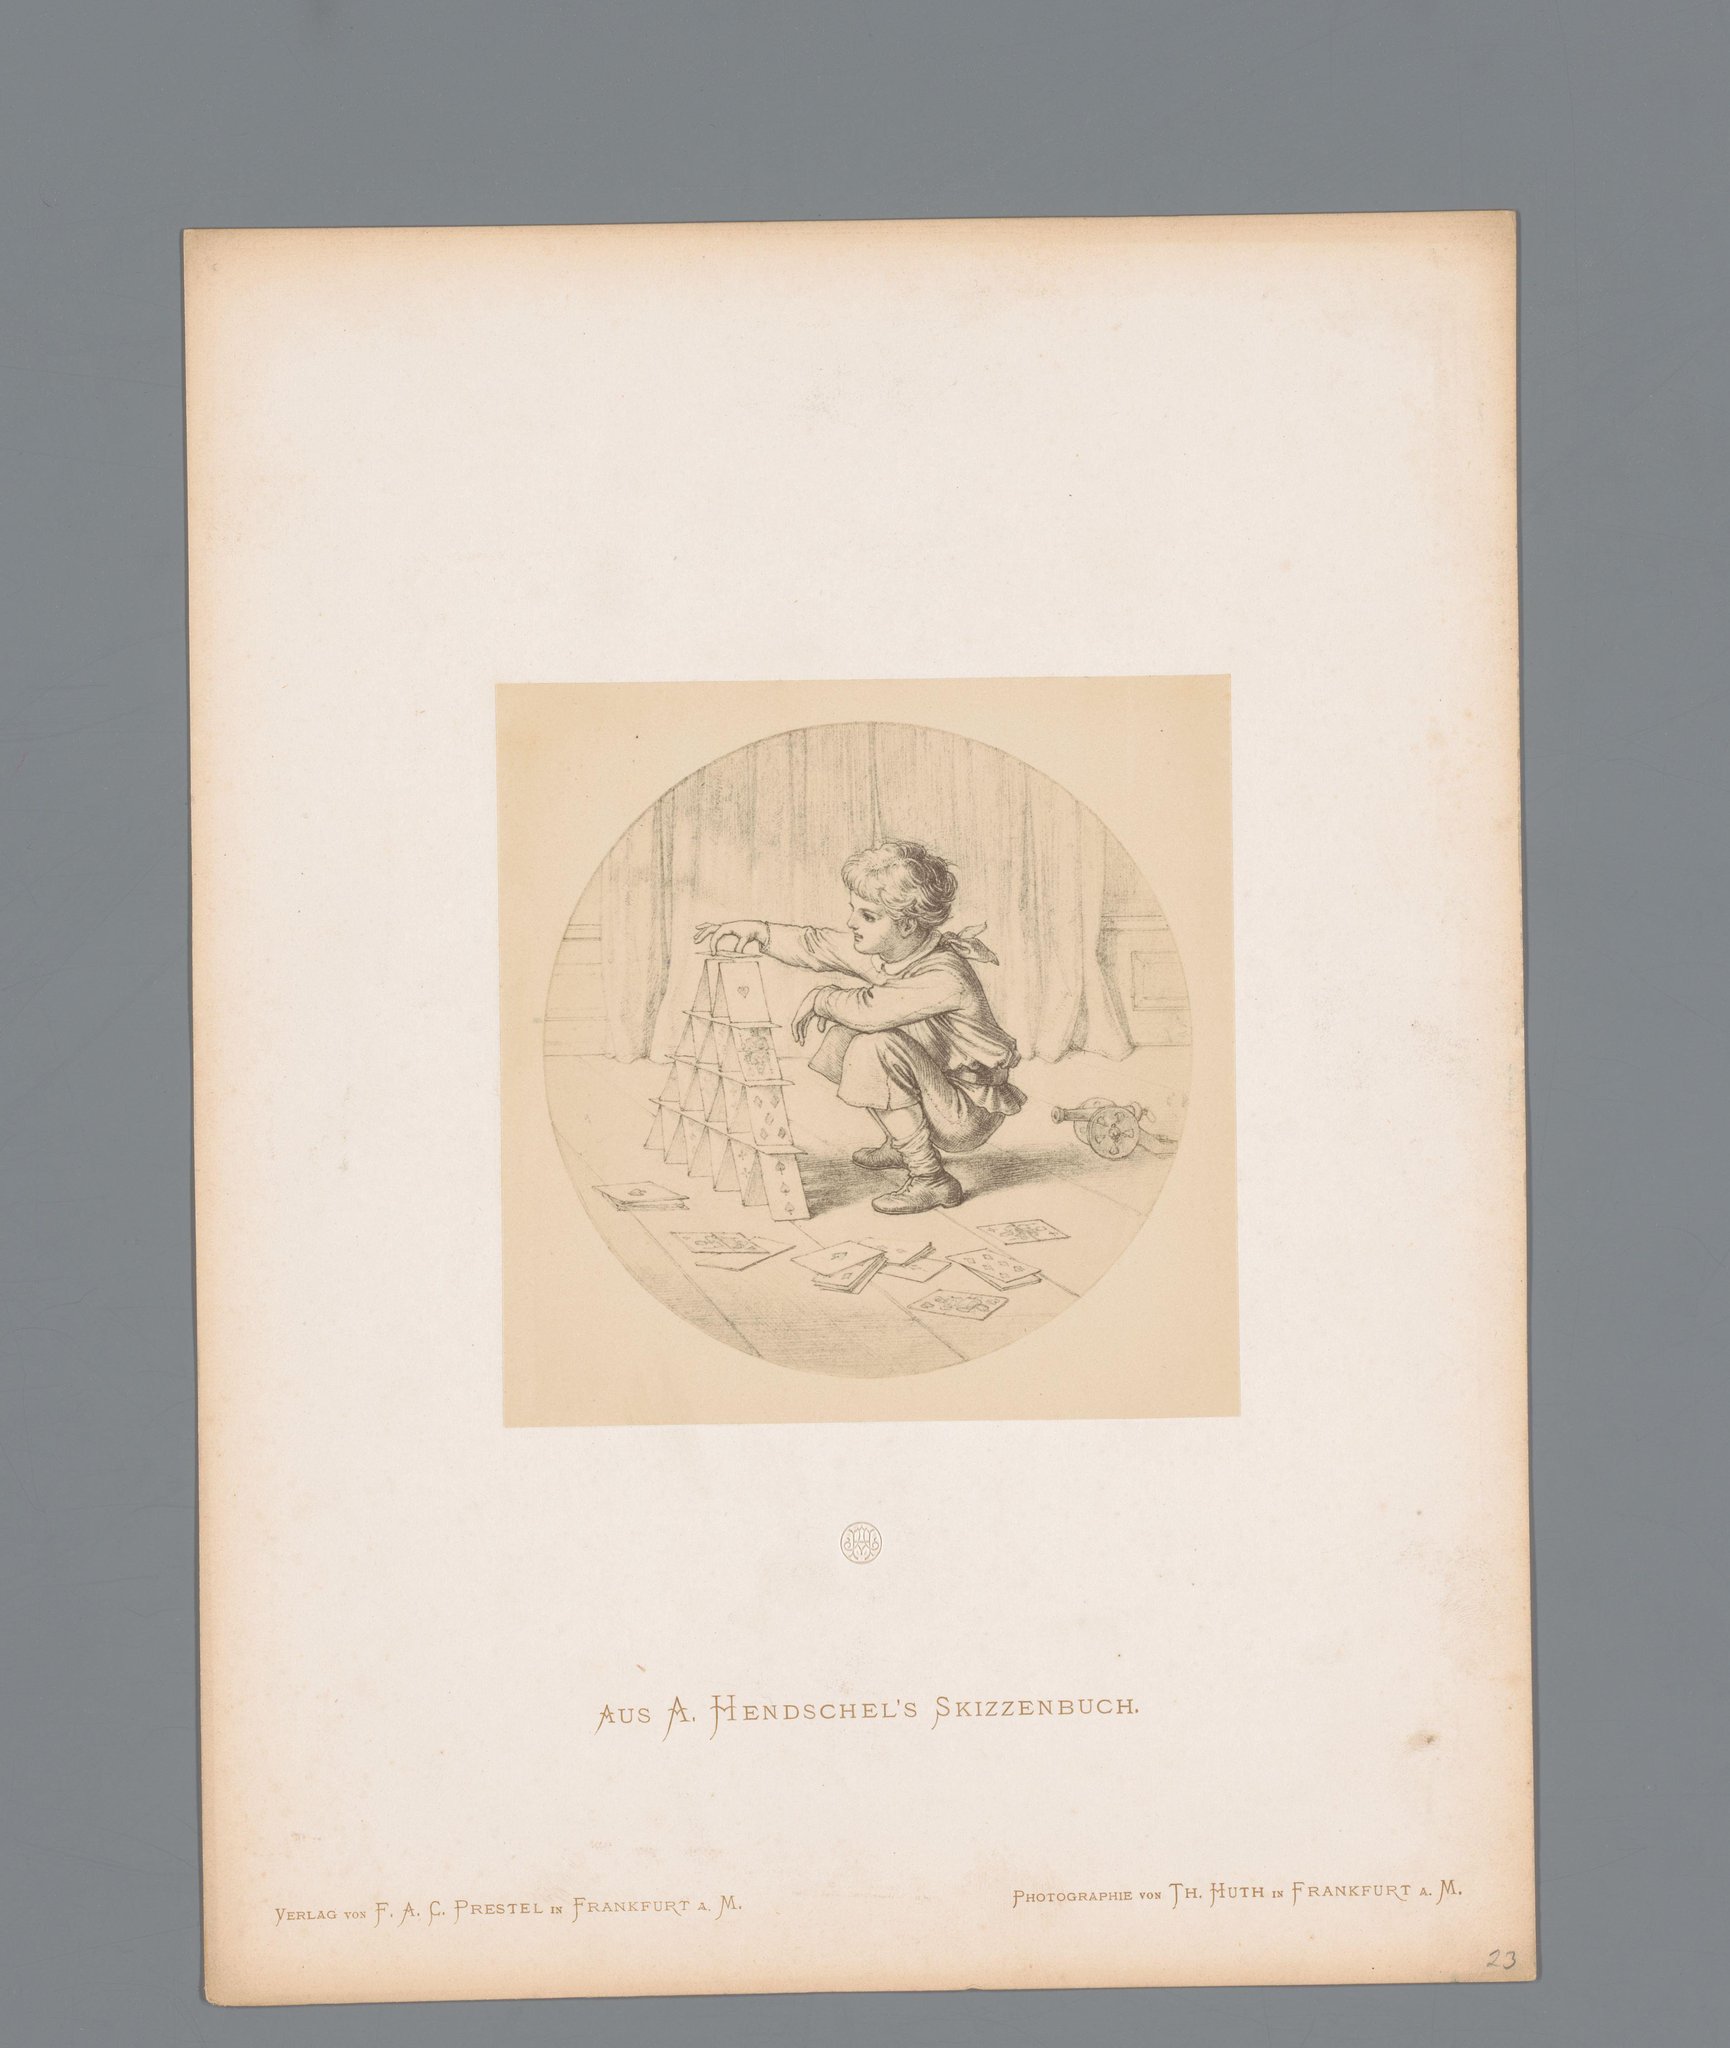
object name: photograph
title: Fotoreproductie van een jongen die een kaartenhuis bouwt door Albert Hendschel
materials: photographic support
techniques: albumen print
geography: frankfurt am main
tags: boy (child between toddler and youth), playing-cards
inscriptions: number: ‘23’, monogram: ‘AH’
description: Deze foto maakt deel uit van een omslag met 50 foto's op 48 bladen, een lijst van afbeeldingen en een titelblad.